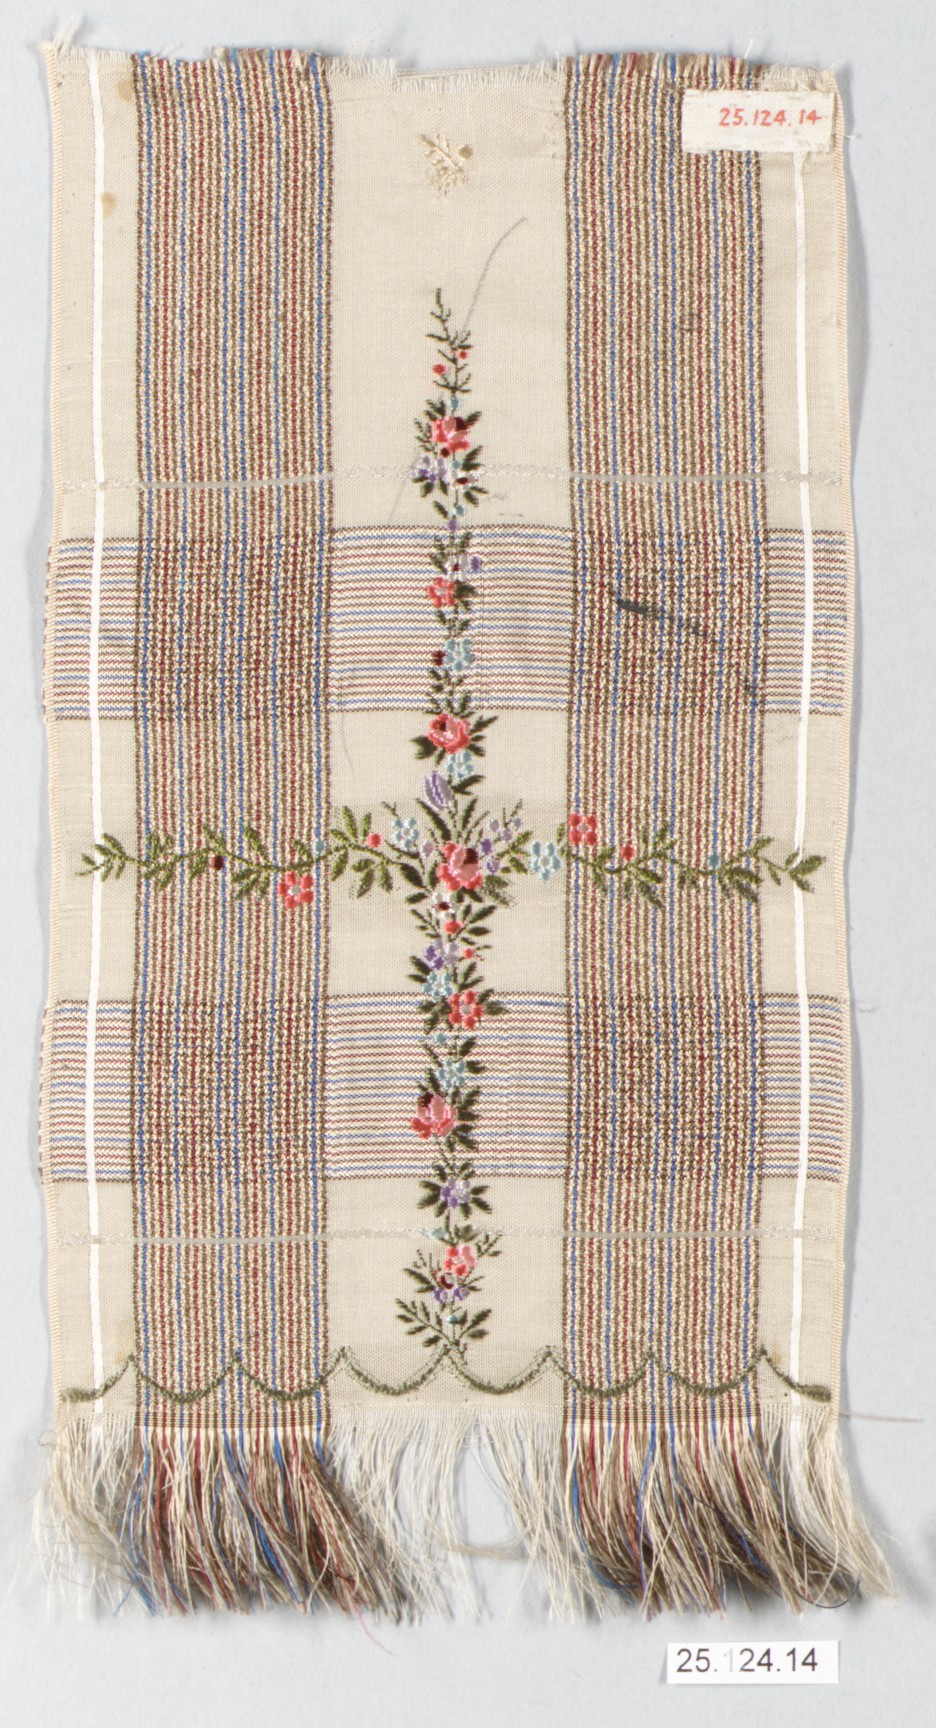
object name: necktie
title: Woman's necktie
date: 1870-1880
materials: silk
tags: flowers